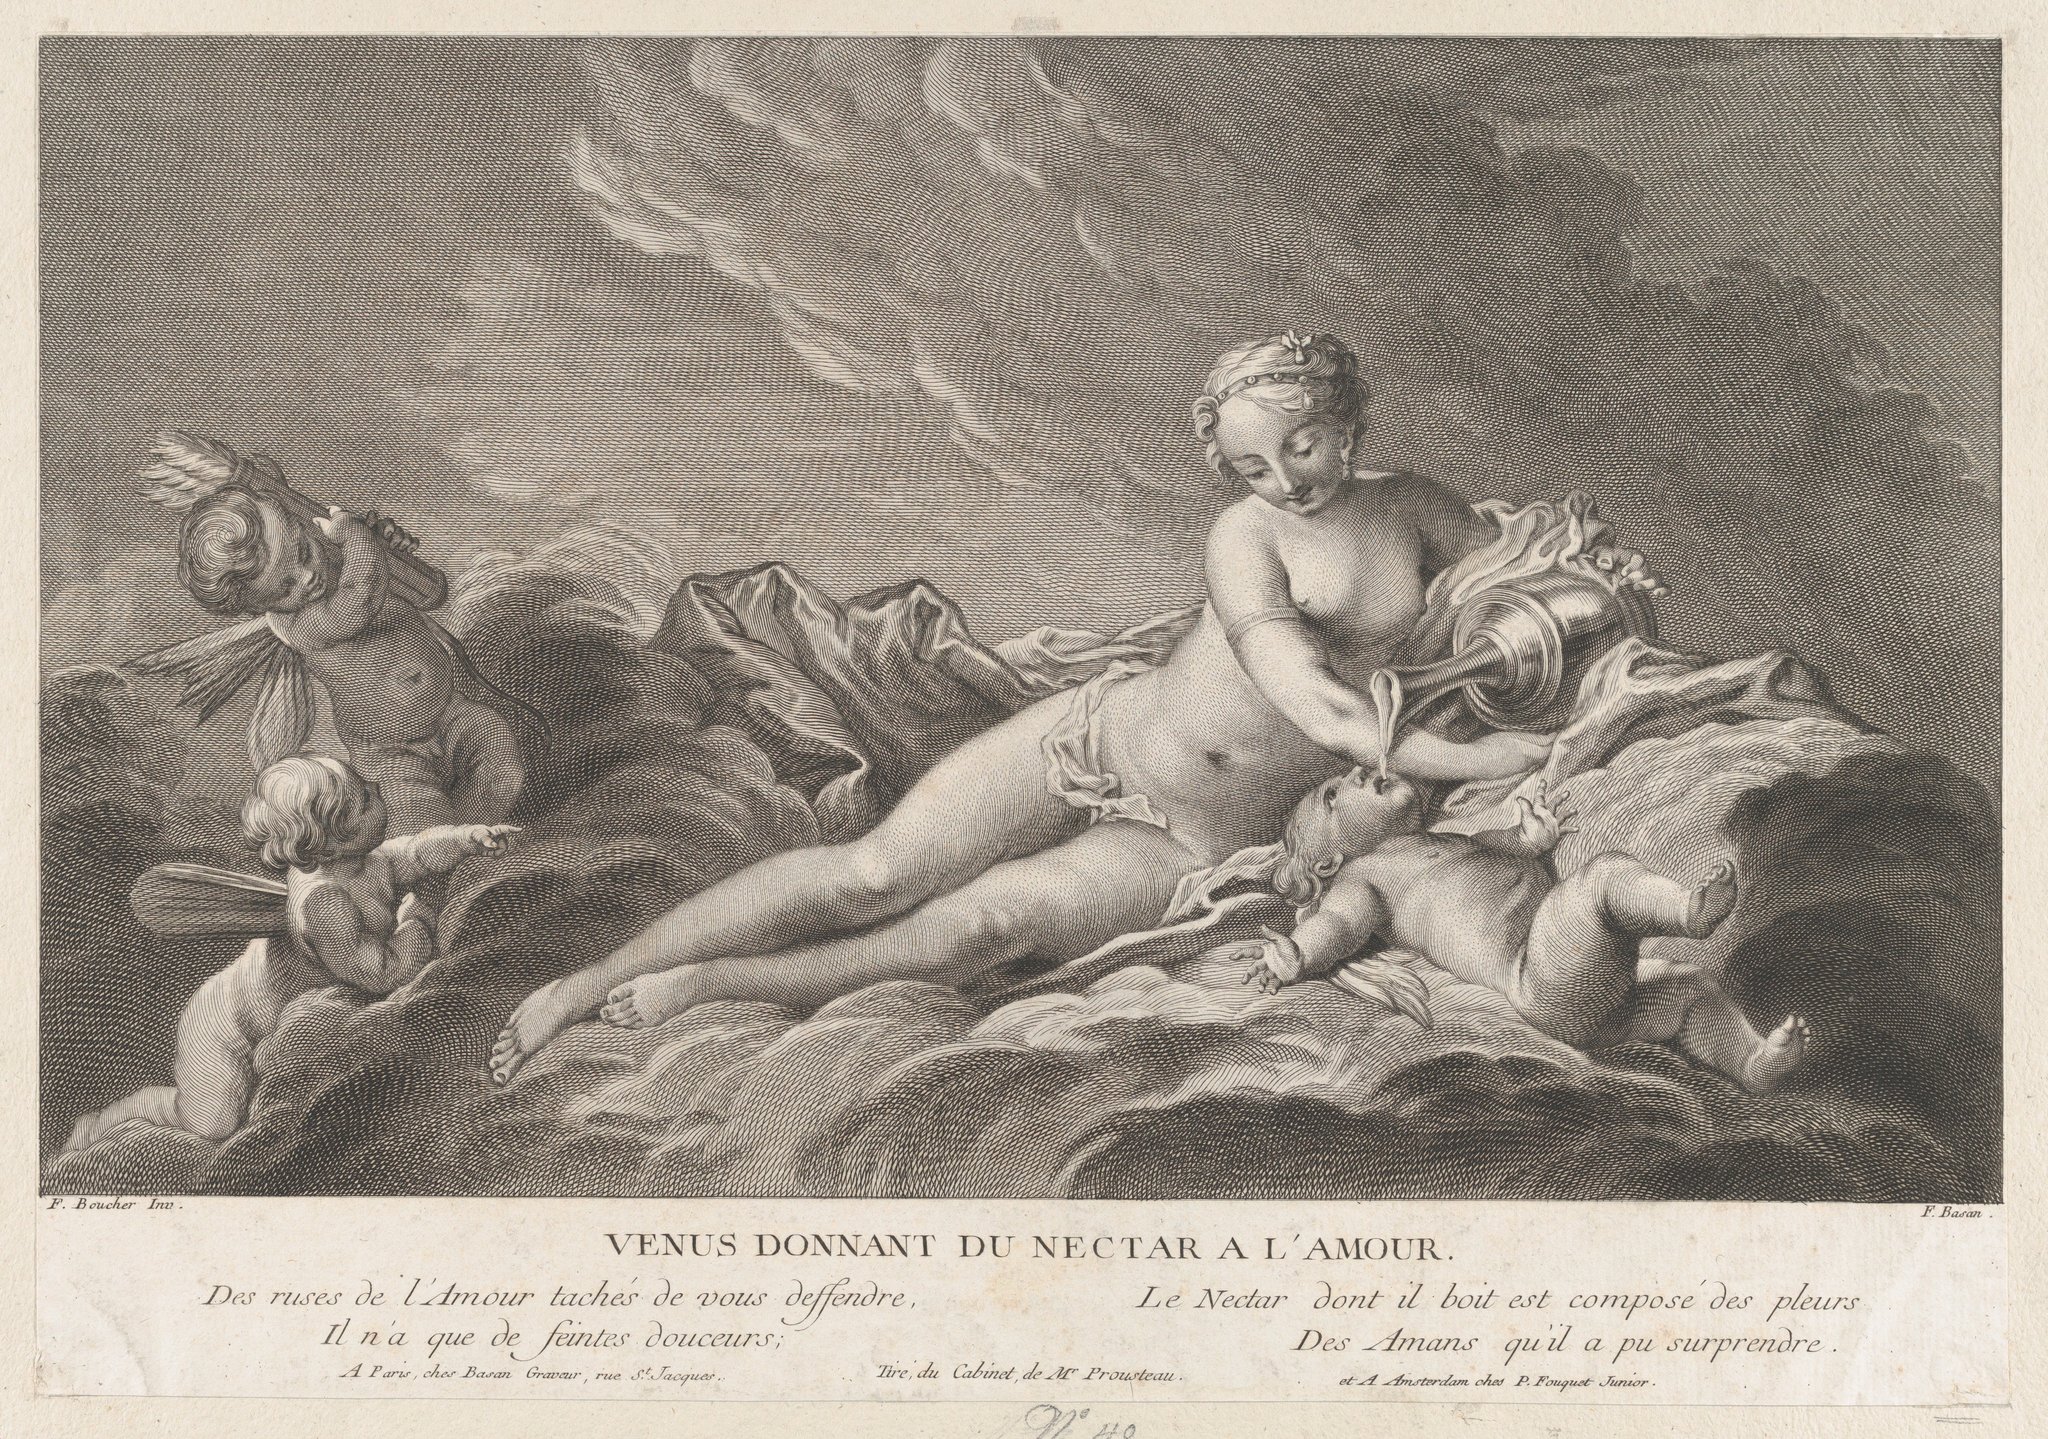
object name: print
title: Venus Giving Nectar to Cupid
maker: pierre françois basan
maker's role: artist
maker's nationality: french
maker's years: 1723-1797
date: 1701-1800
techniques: engraving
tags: cupid,venus